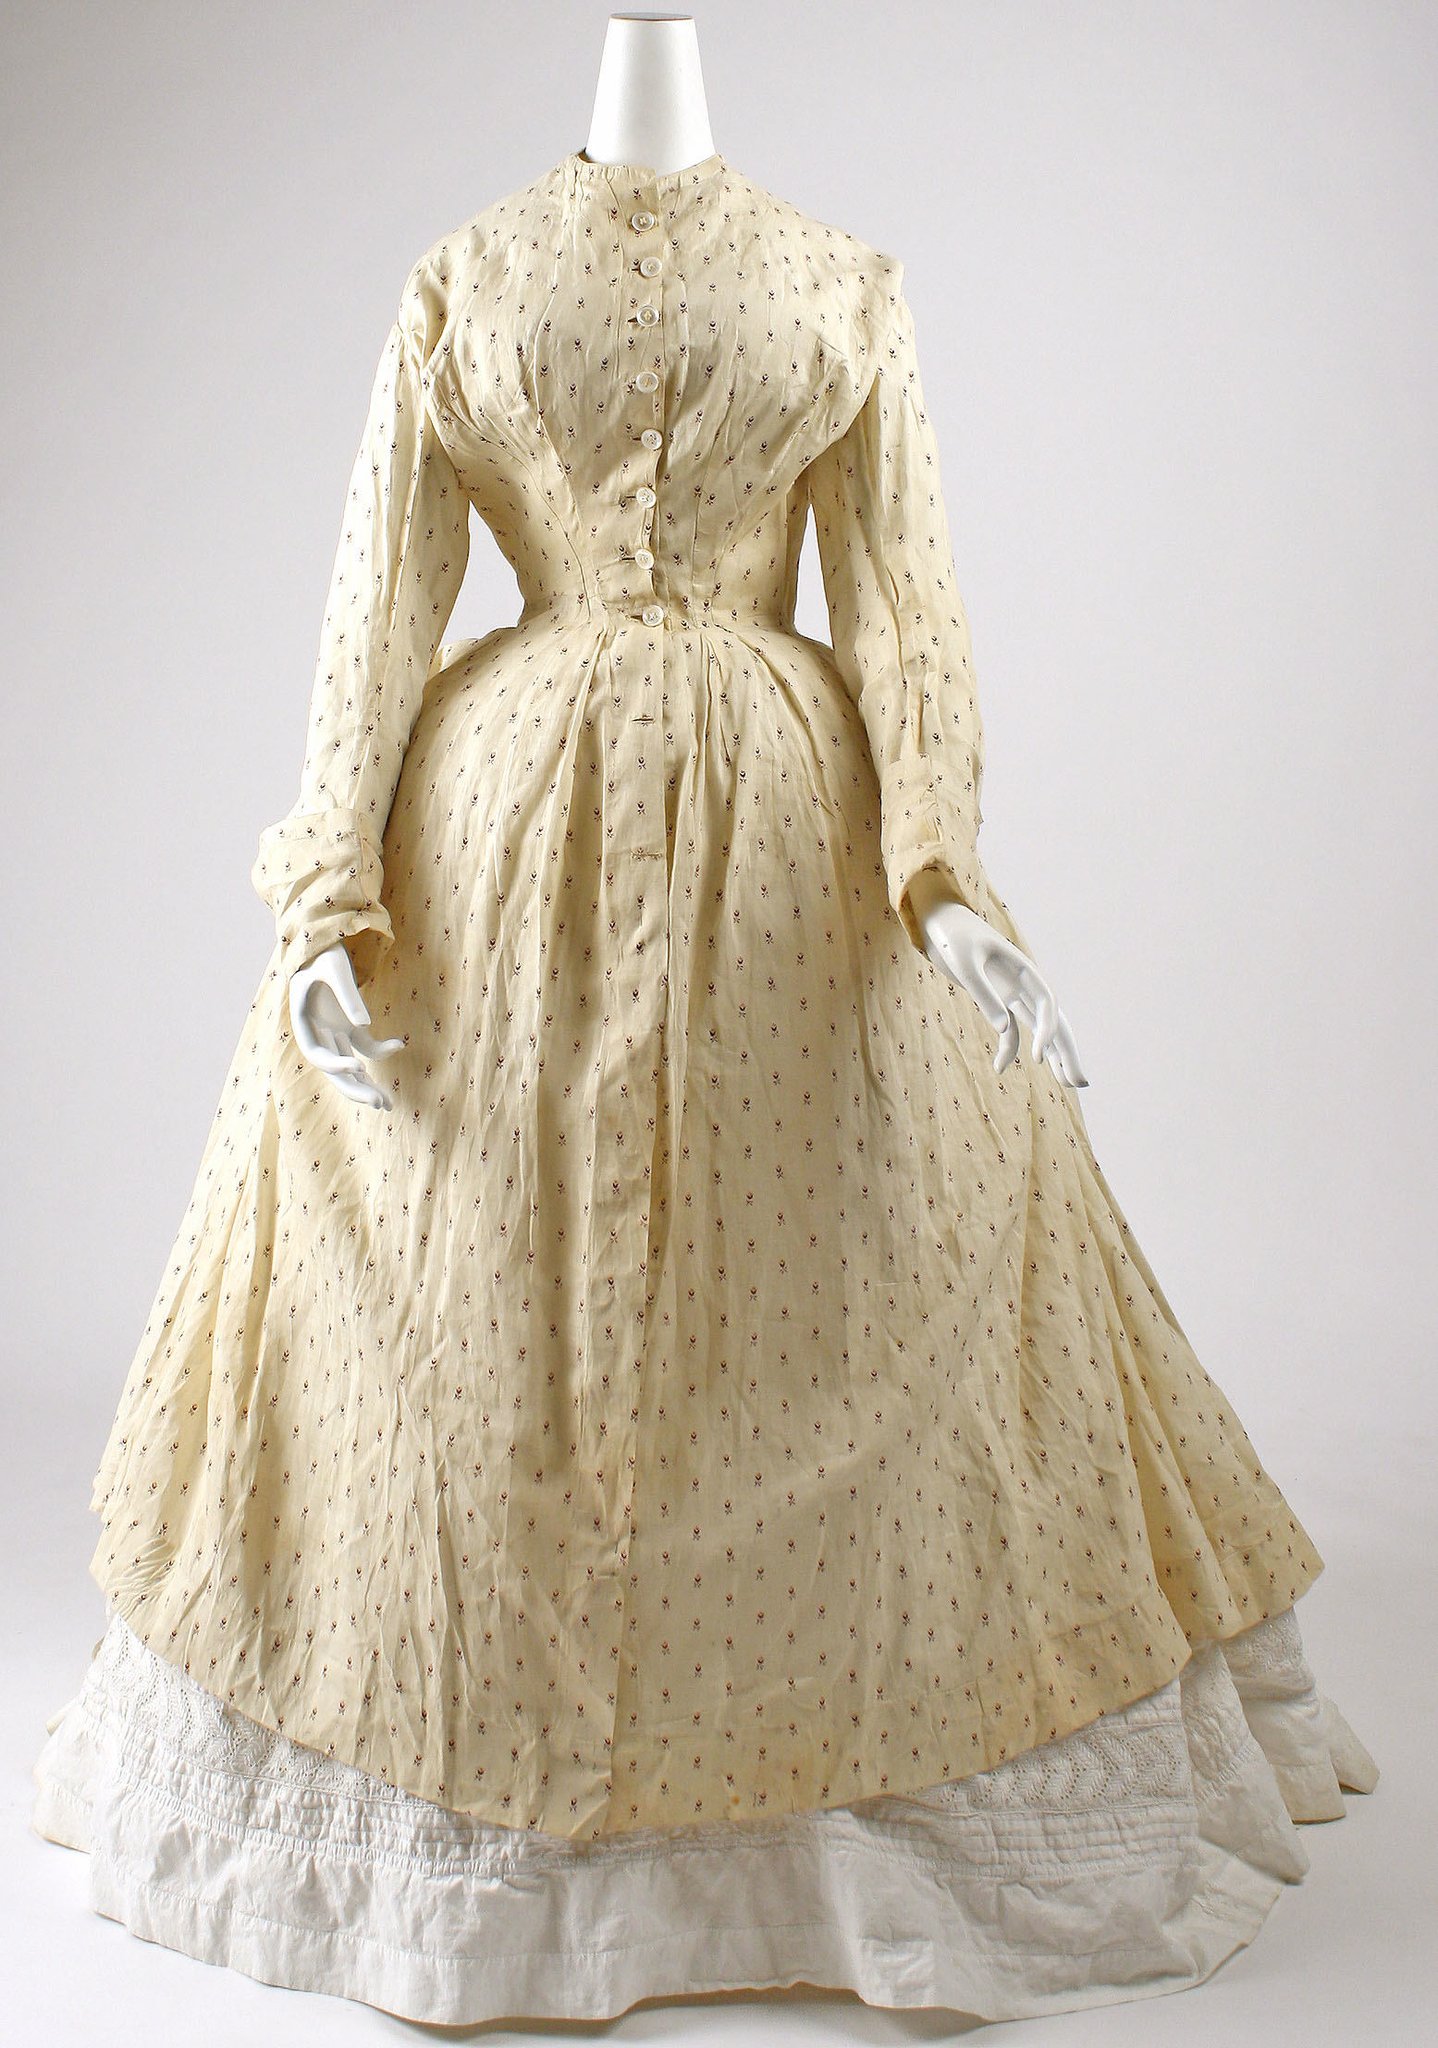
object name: robe à la polonaise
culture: american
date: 1865-1875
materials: linen